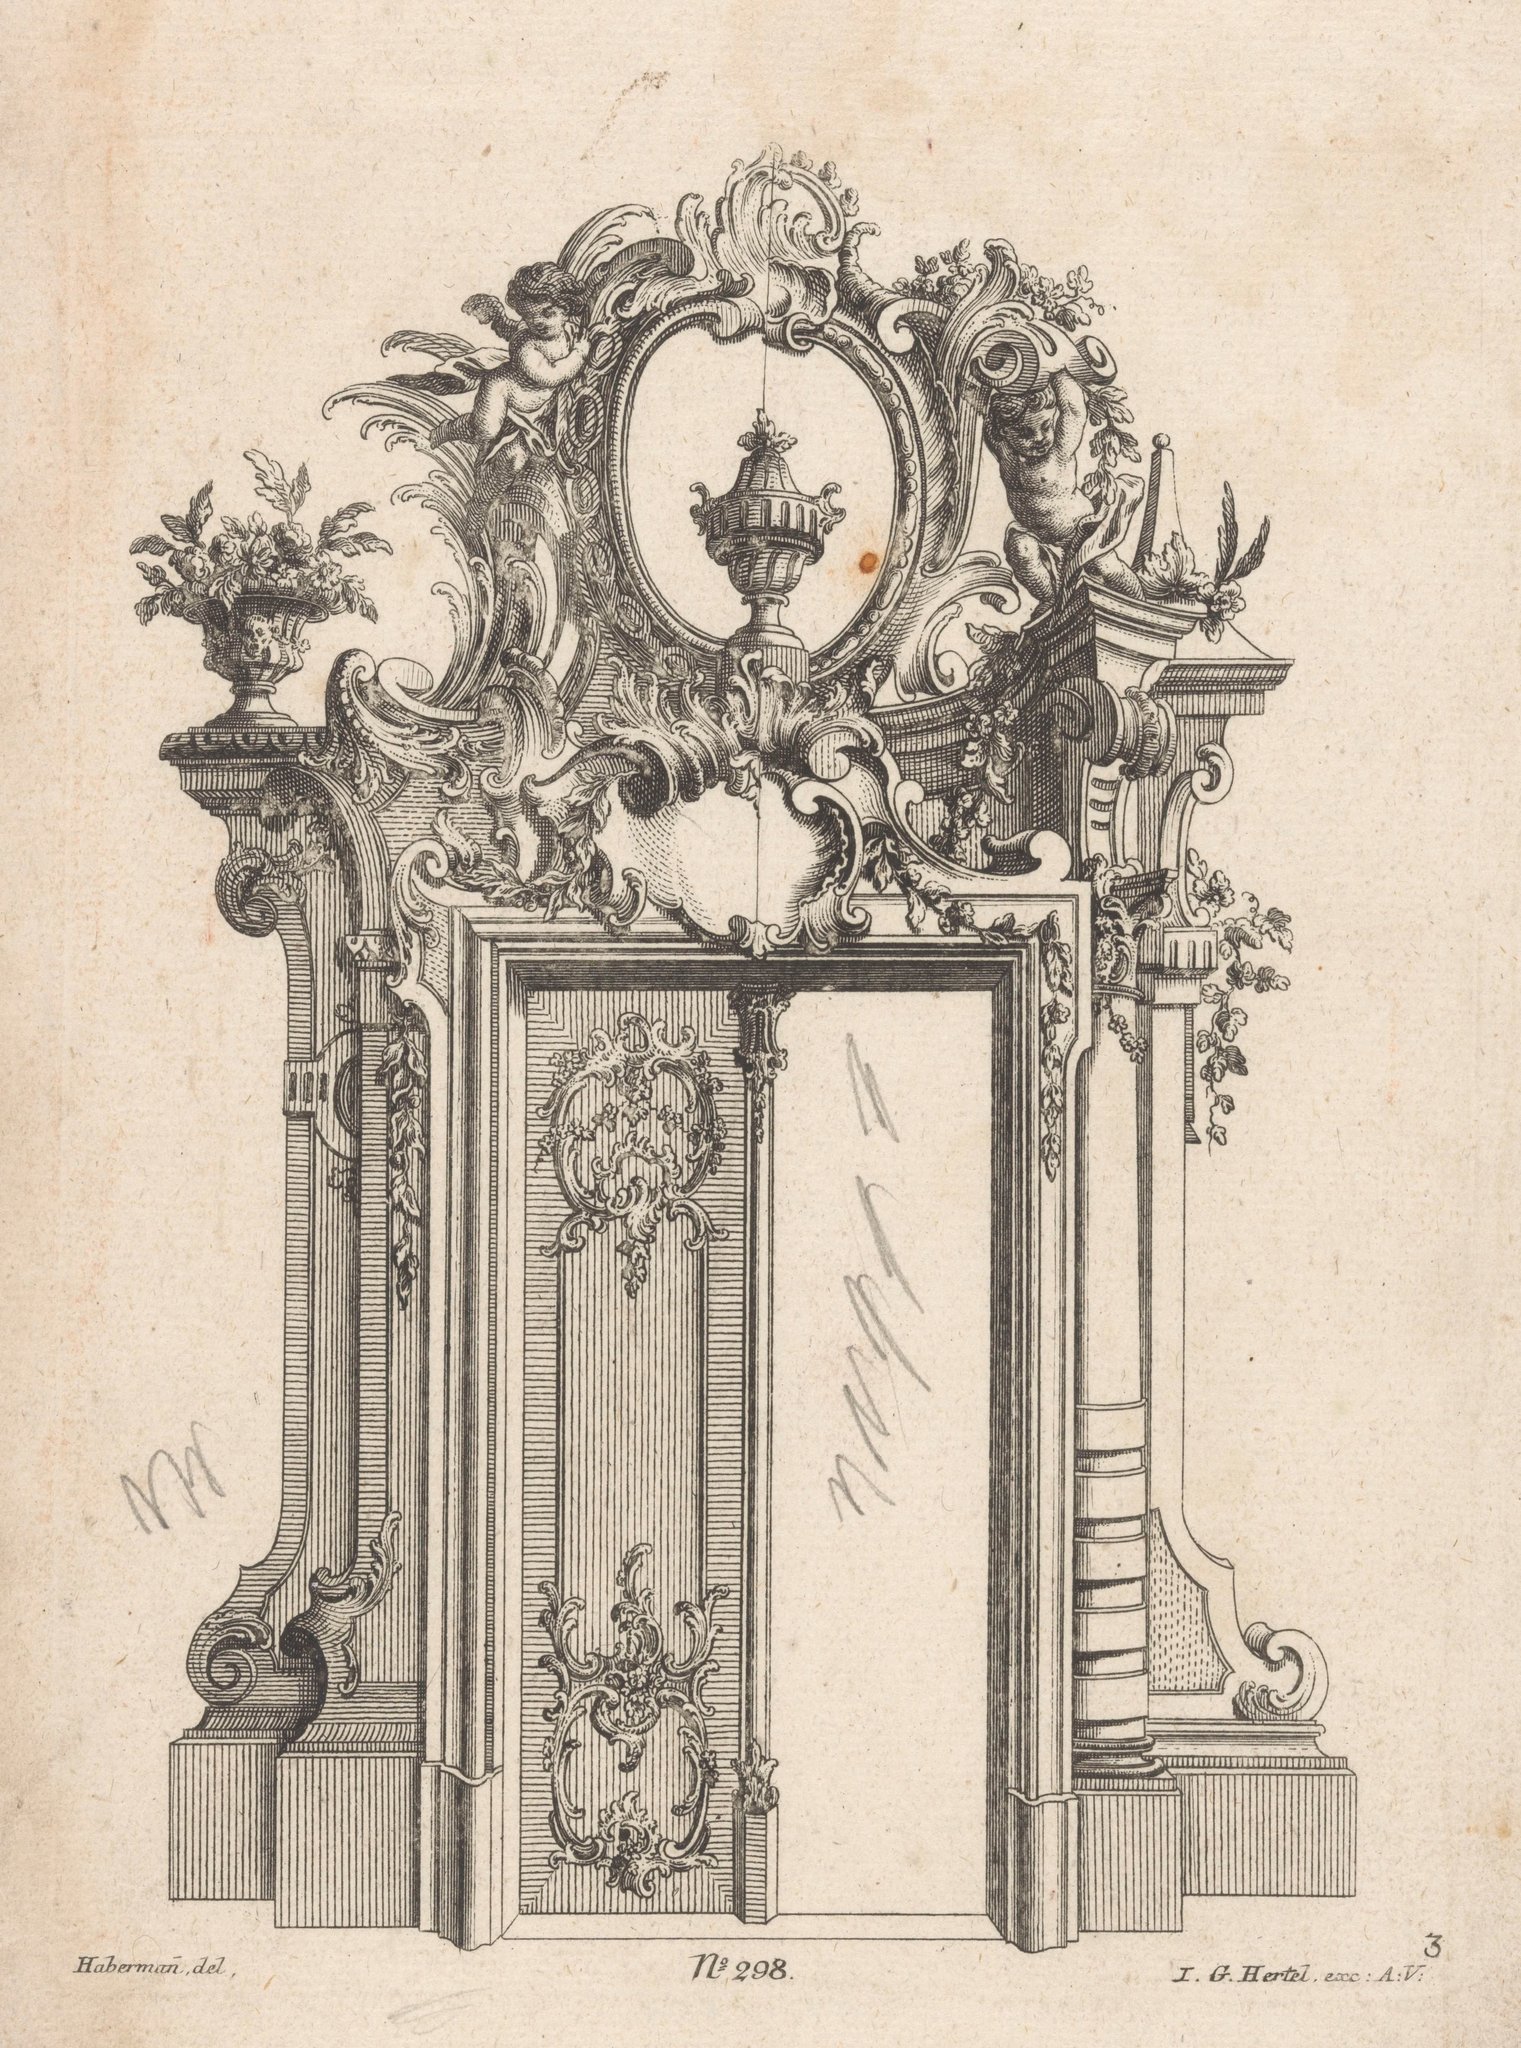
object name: ornament print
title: Deuromlijstingen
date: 1750-1760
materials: paper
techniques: engraving, etching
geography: augsburg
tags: rocaille ornament, vase ~ ornament, door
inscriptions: collector's mark: Lugt 2760, collector's mark: Lugt 2228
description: Deuromlijsting met rocaille ornamenten, bladmotieven, twee putti, een vaas met bloemen links en een vaas boven. Uitgeversnummer 298.